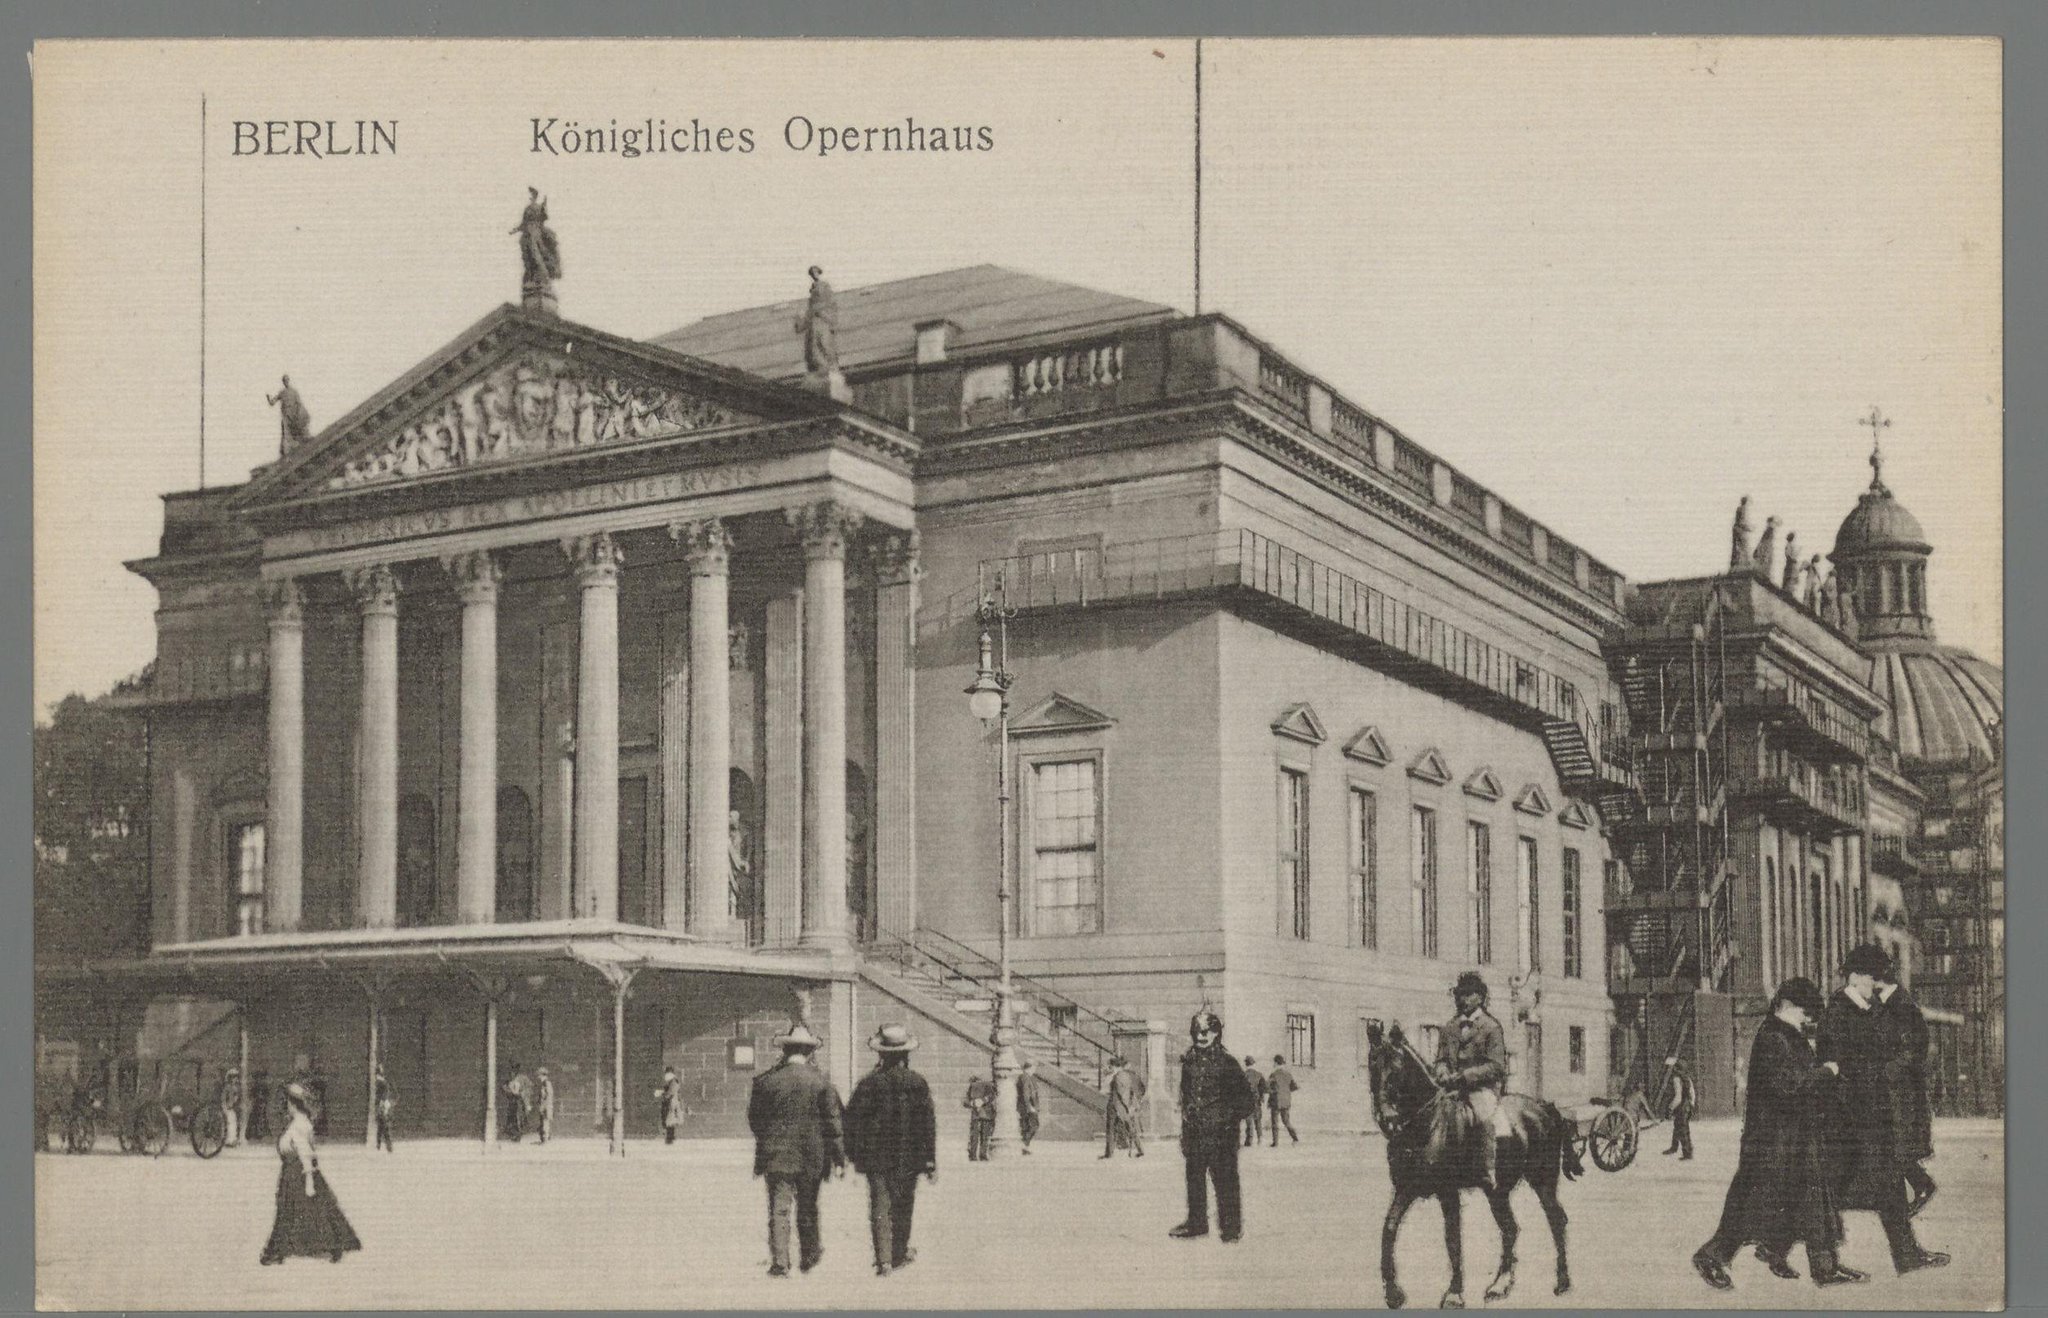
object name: photomechanical print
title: Berlin. Königliches Opernhaus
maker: Anonymous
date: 1905-1930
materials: cardboard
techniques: photograph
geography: berlin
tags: opera house